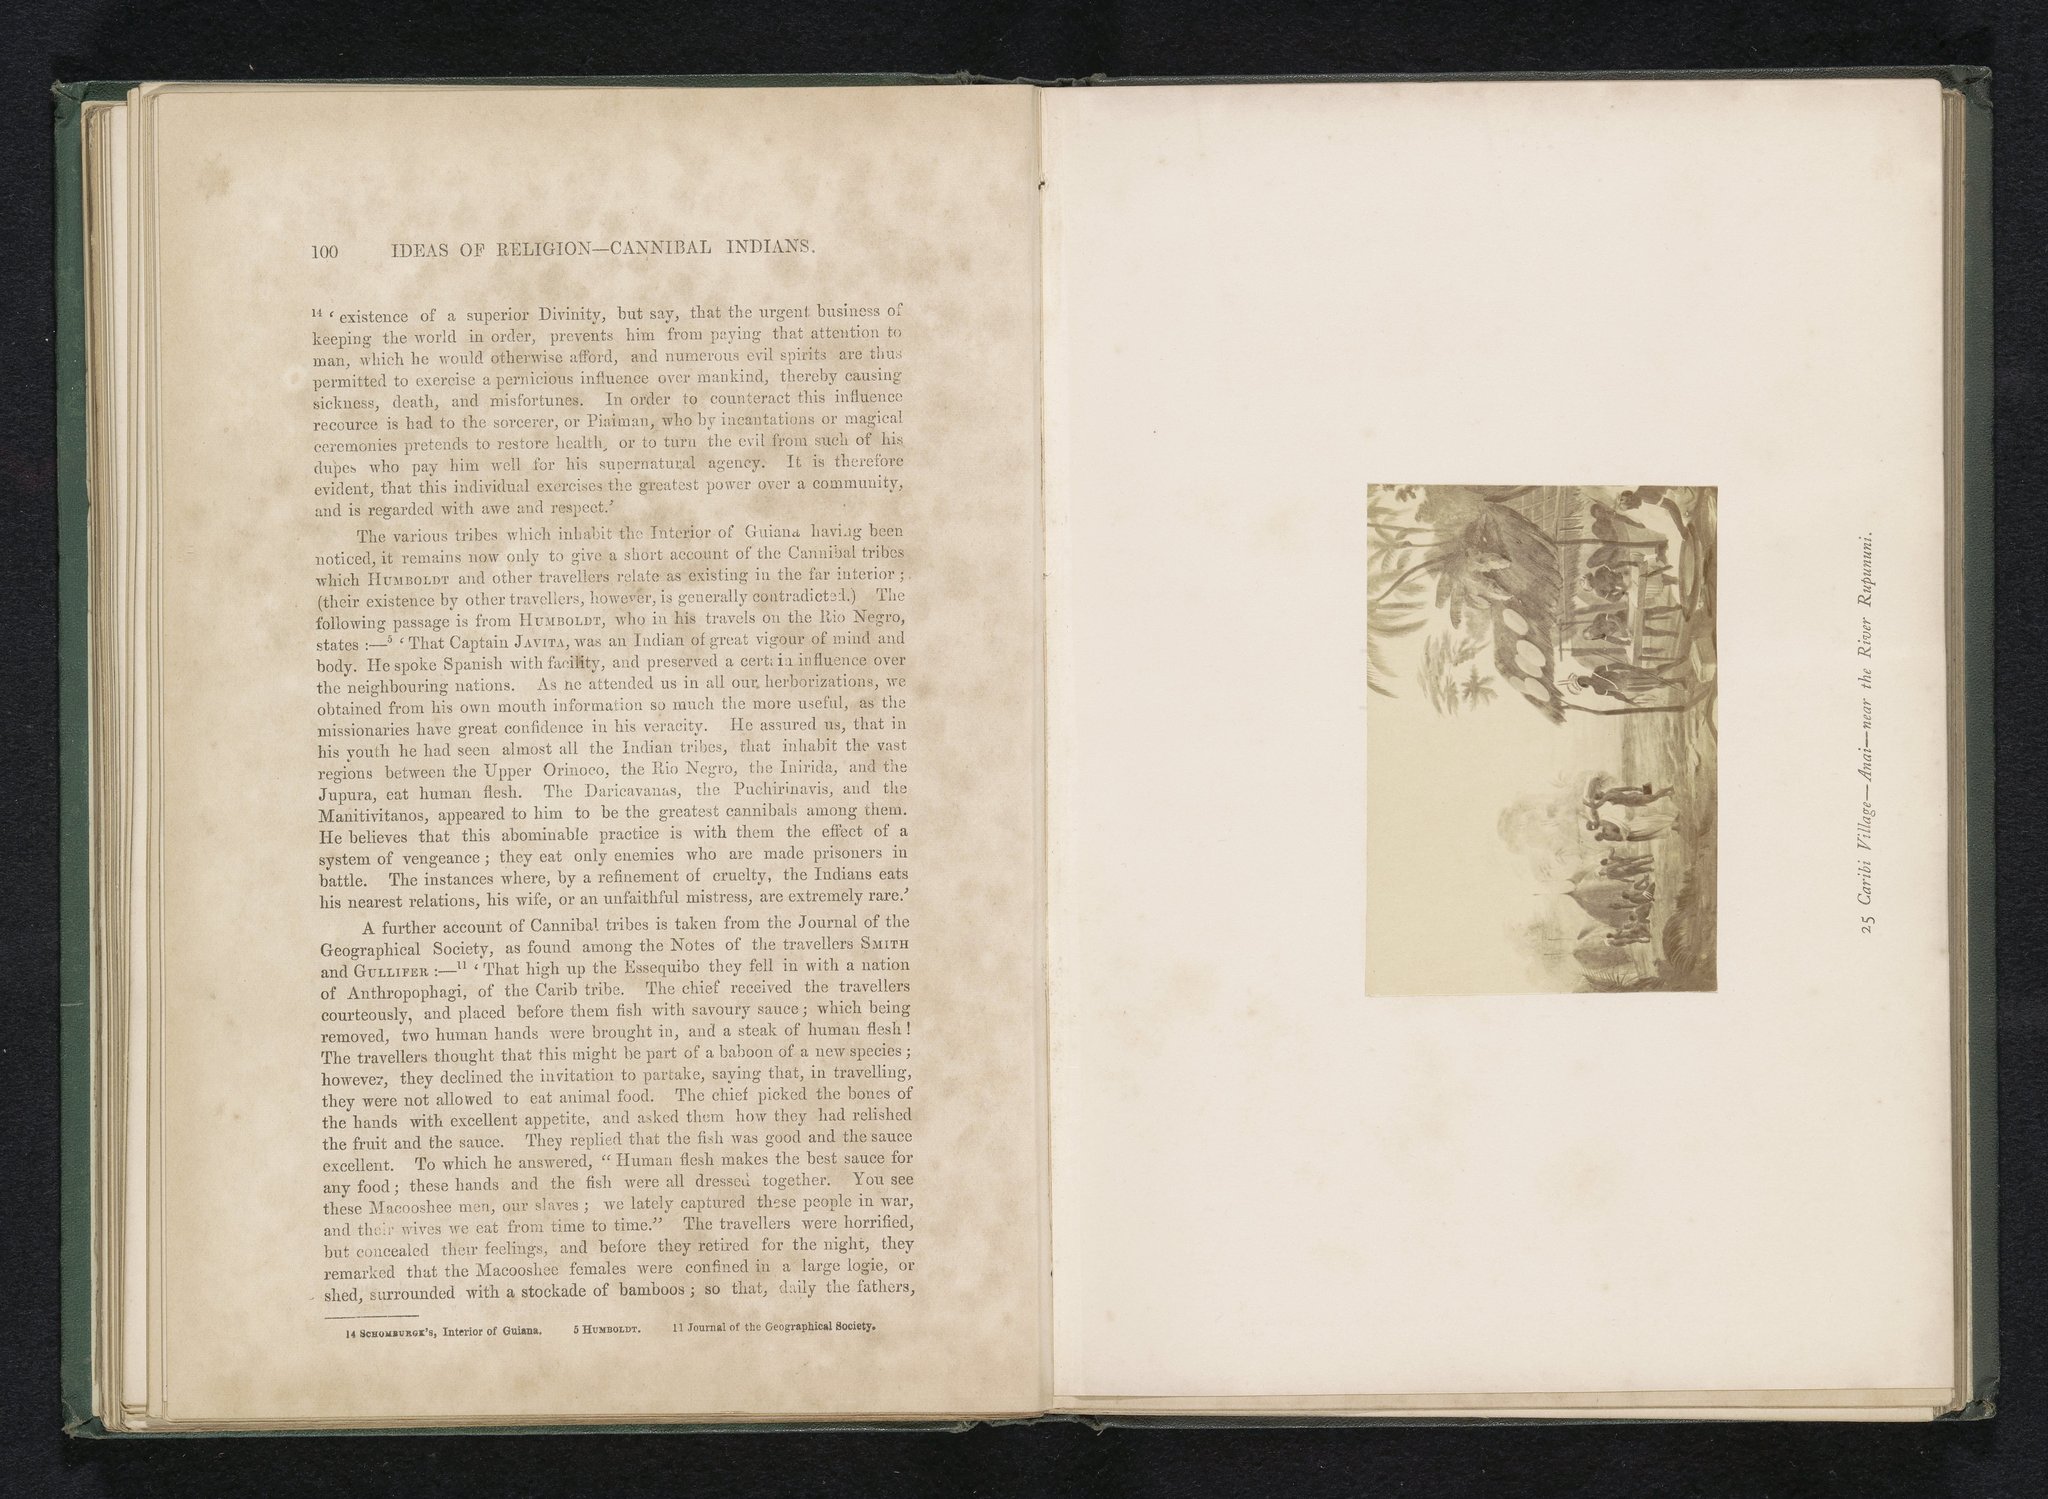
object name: reproduction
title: Caribi Village-Anai- near the River Rupununi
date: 1856-1866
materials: photographic support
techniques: albumen print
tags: village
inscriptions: number: ‘25’